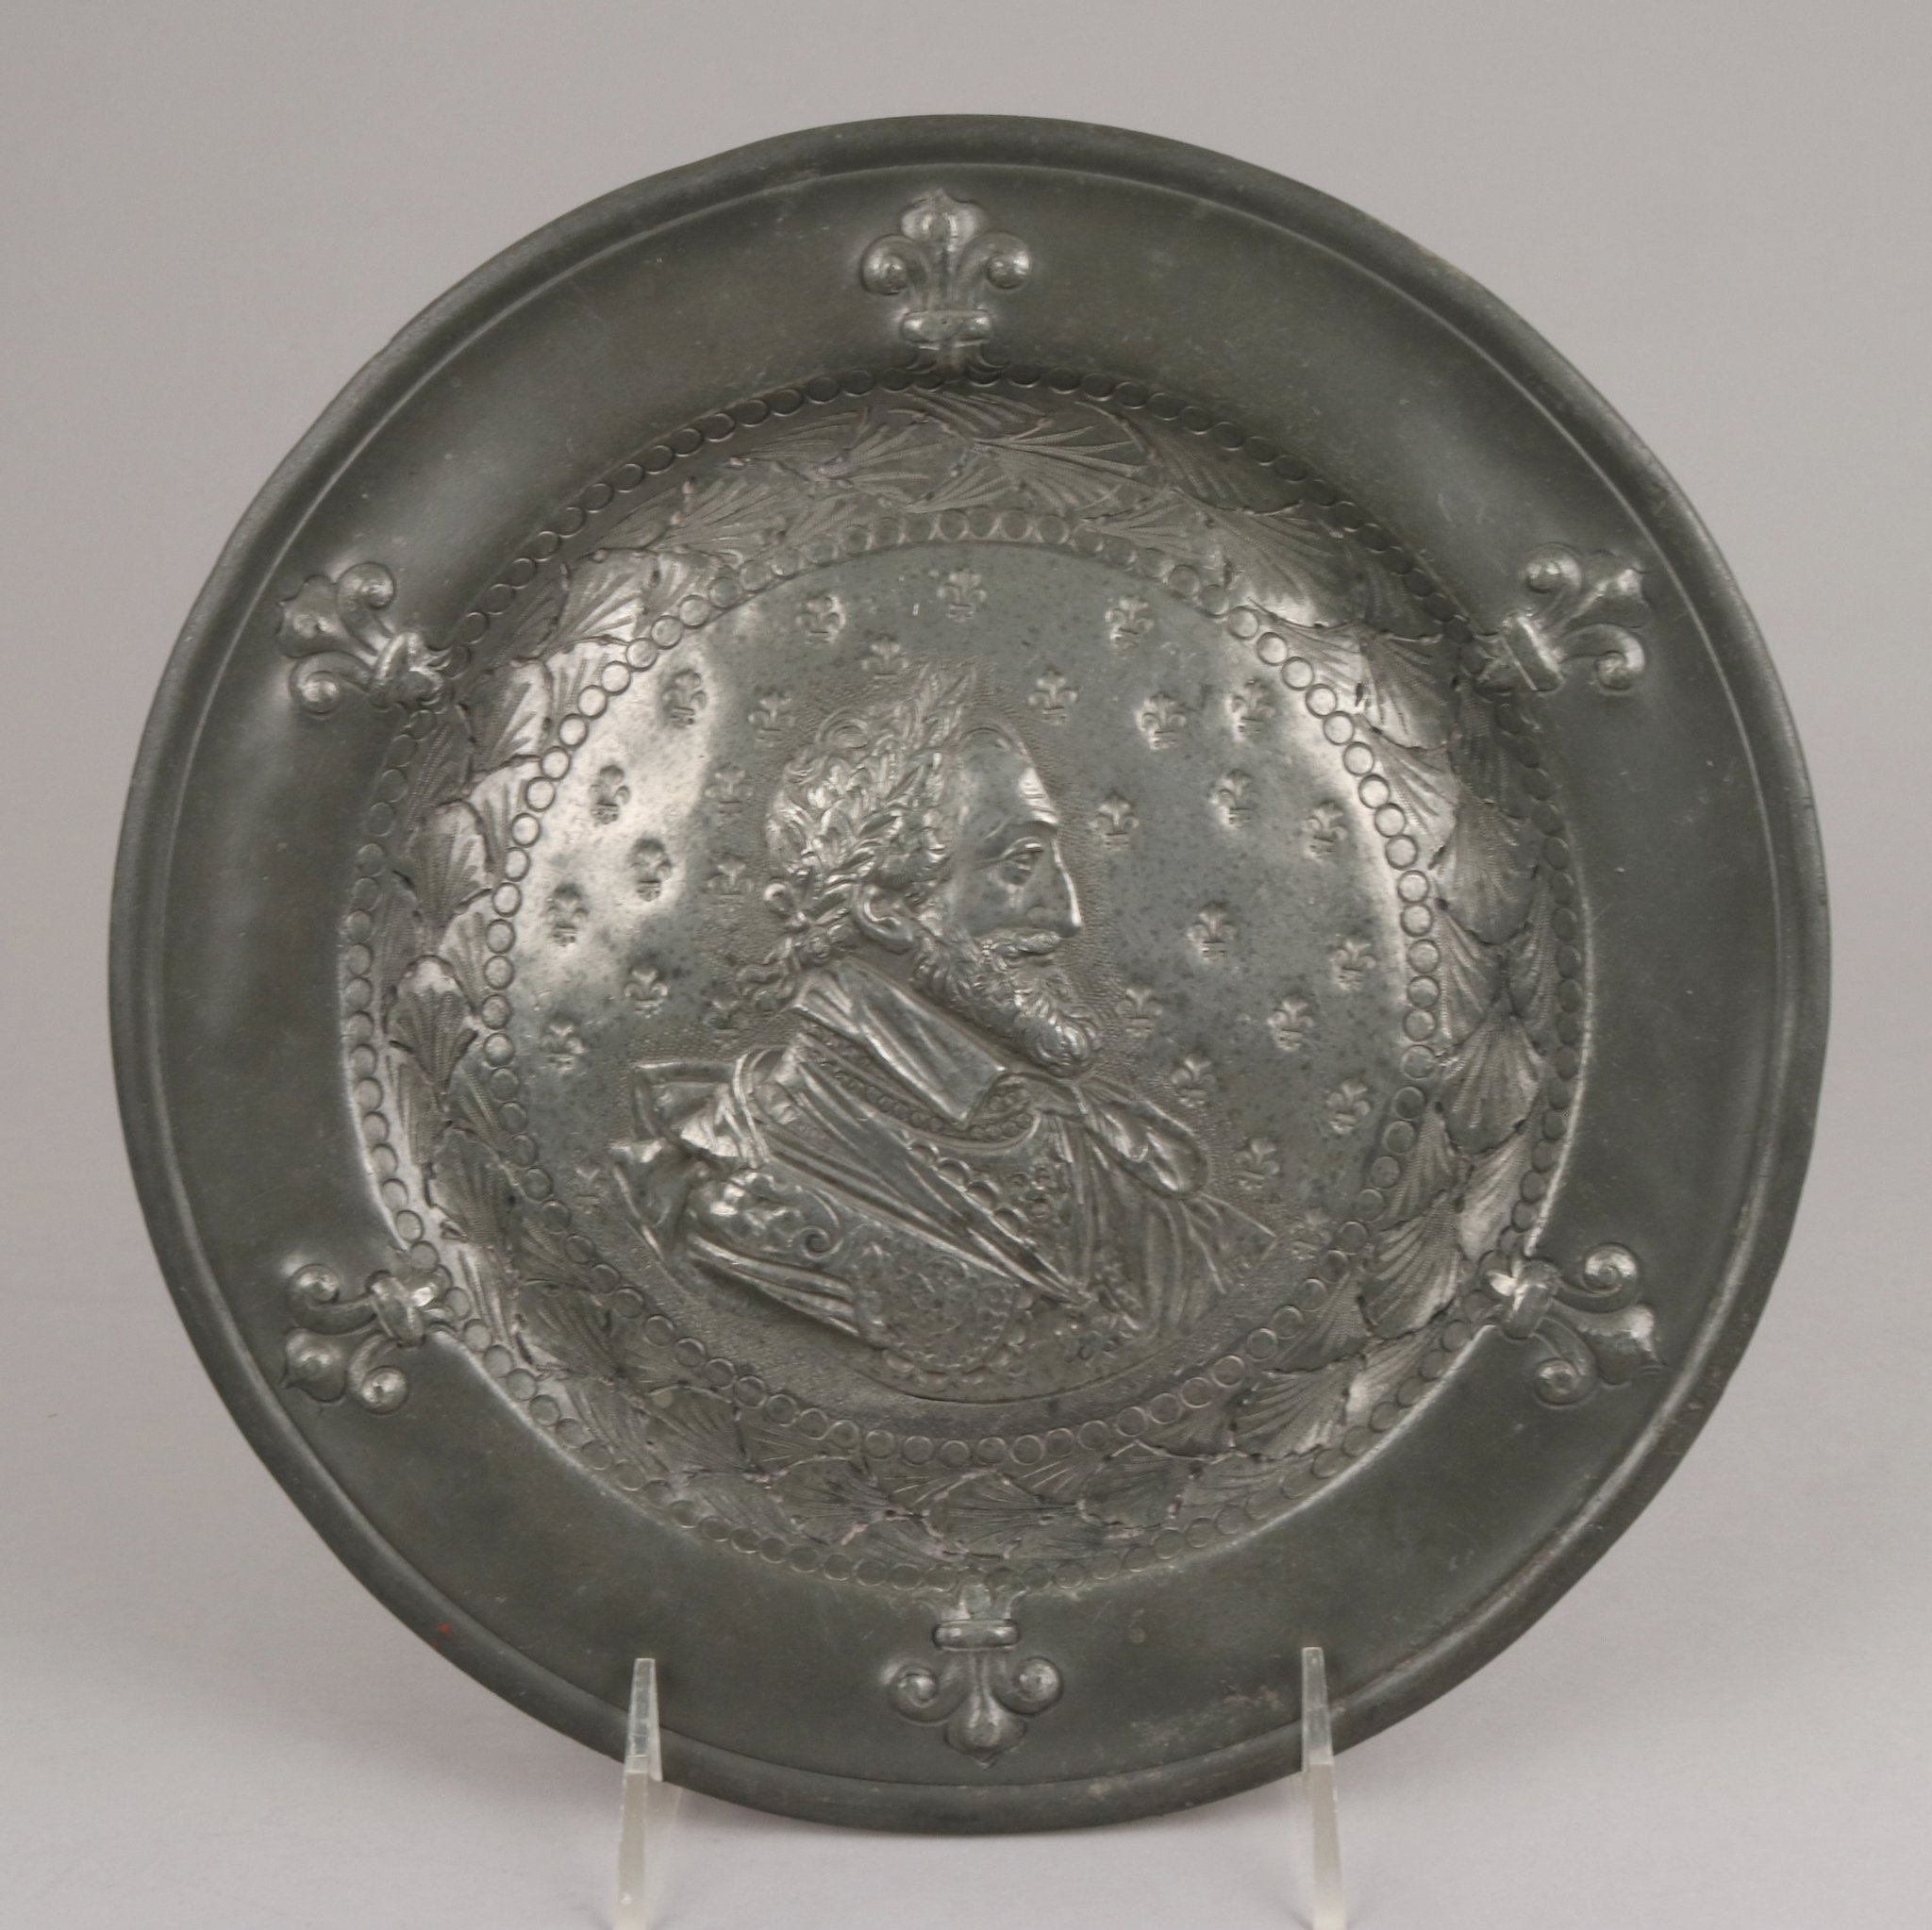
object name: plate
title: Plate with relief portrait of Henry IV of France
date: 1801-1900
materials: pewter